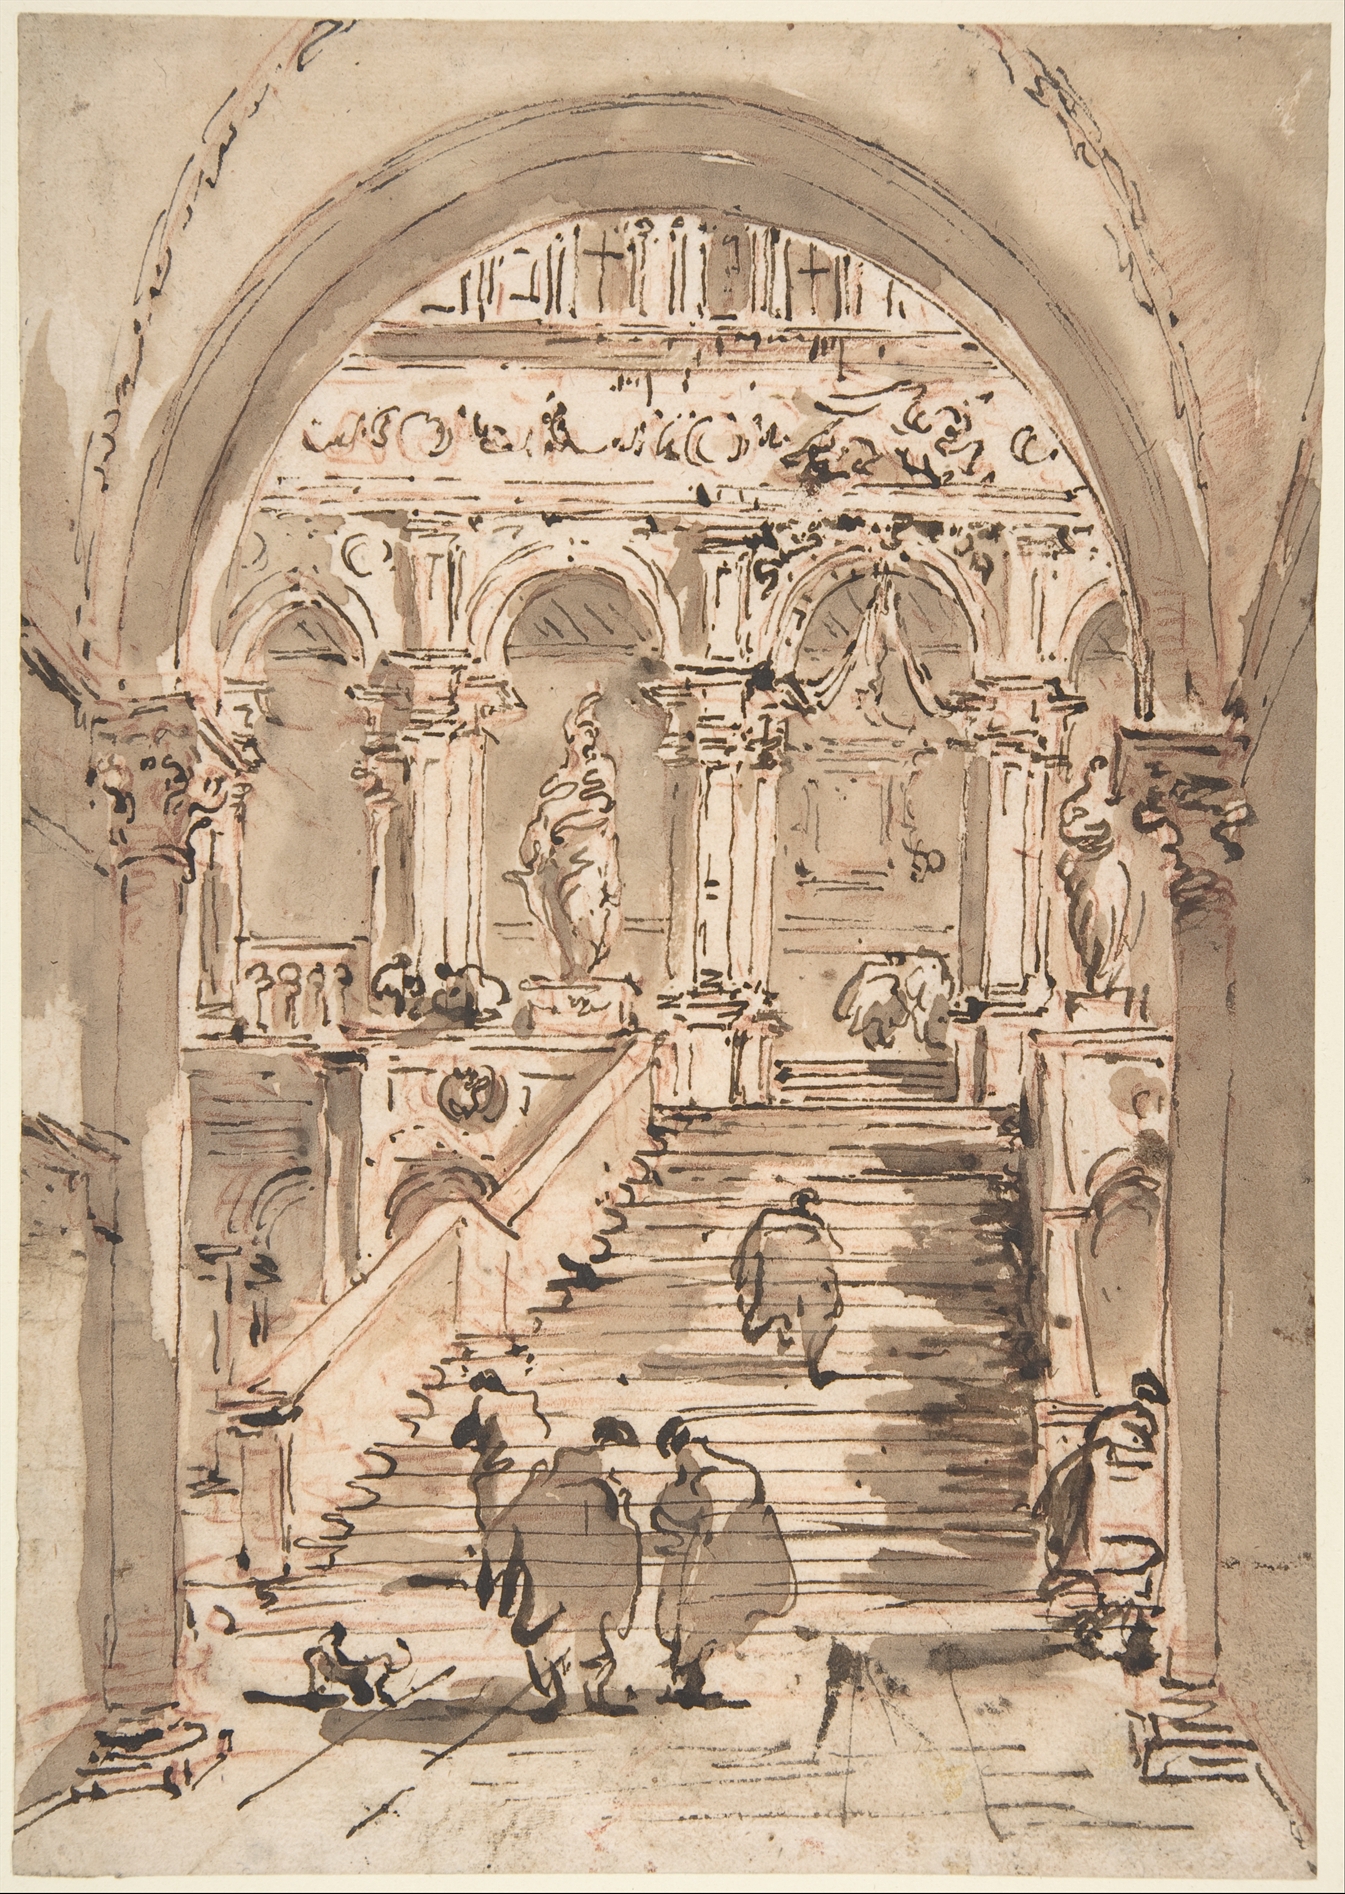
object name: drawing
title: The Staircase of the Giants, Ducal Palace, Venice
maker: francesco guardi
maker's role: artist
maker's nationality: italian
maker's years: 1712-1793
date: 1712-1793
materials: chalk, ink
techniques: brush, pen, wash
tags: arches,stairs,venice